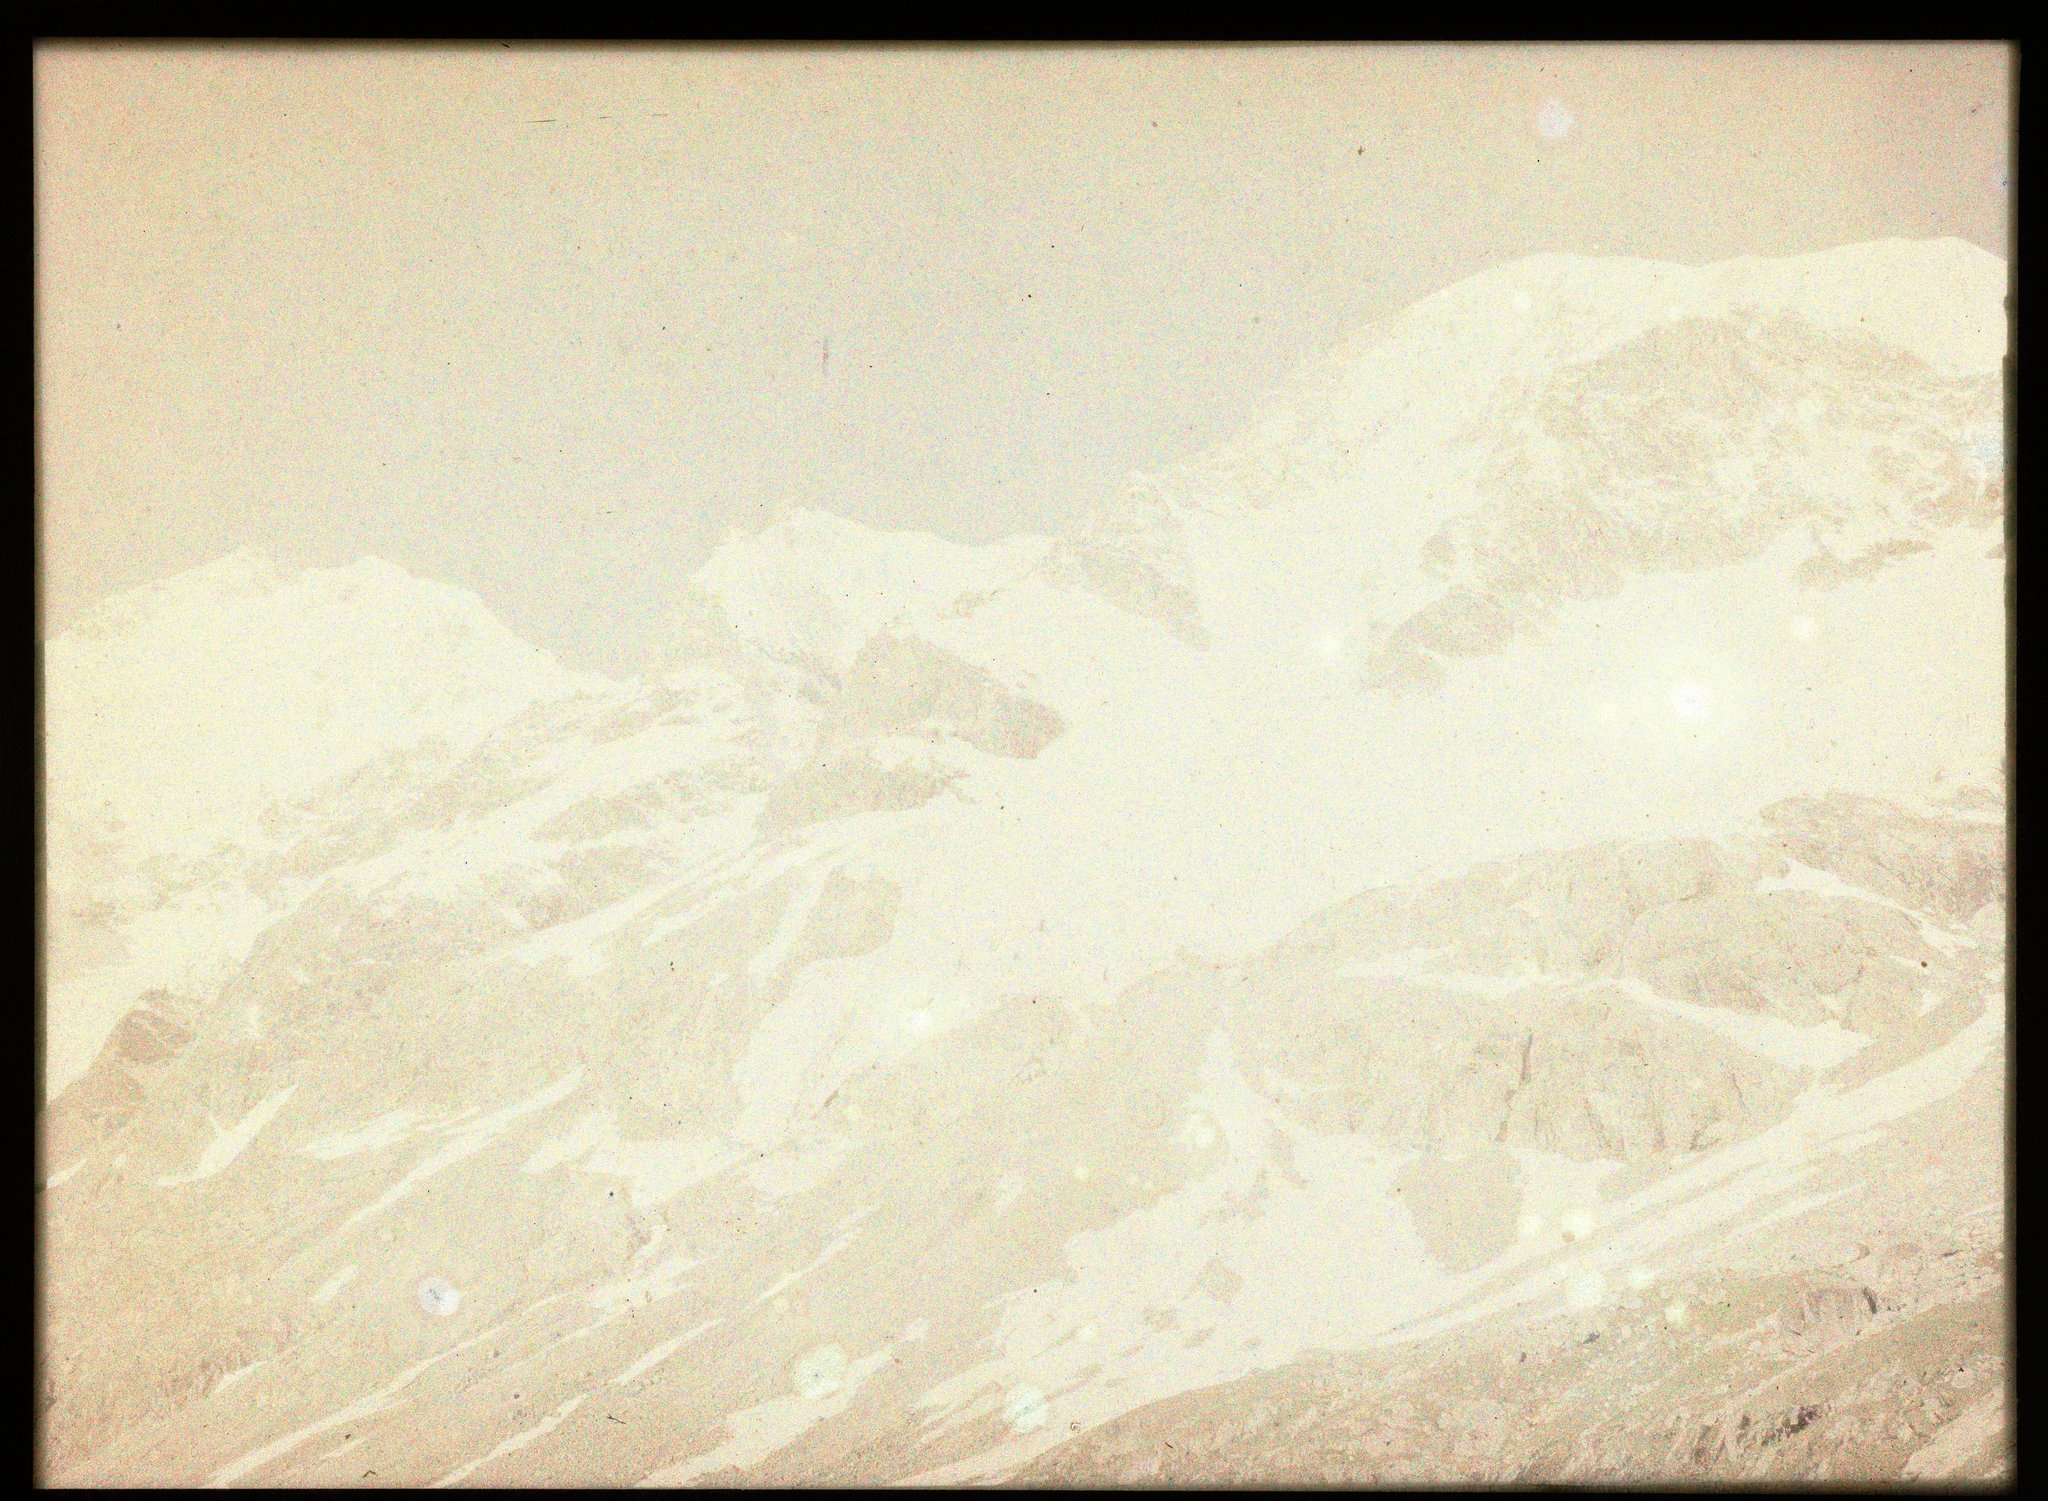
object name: color slide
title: Gezicht op een bergwand met sneeuw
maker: adolphe burdet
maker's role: fotograaf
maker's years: 1860-1940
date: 1907-1930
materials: glass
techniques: autochrome process, slide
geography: netherlands